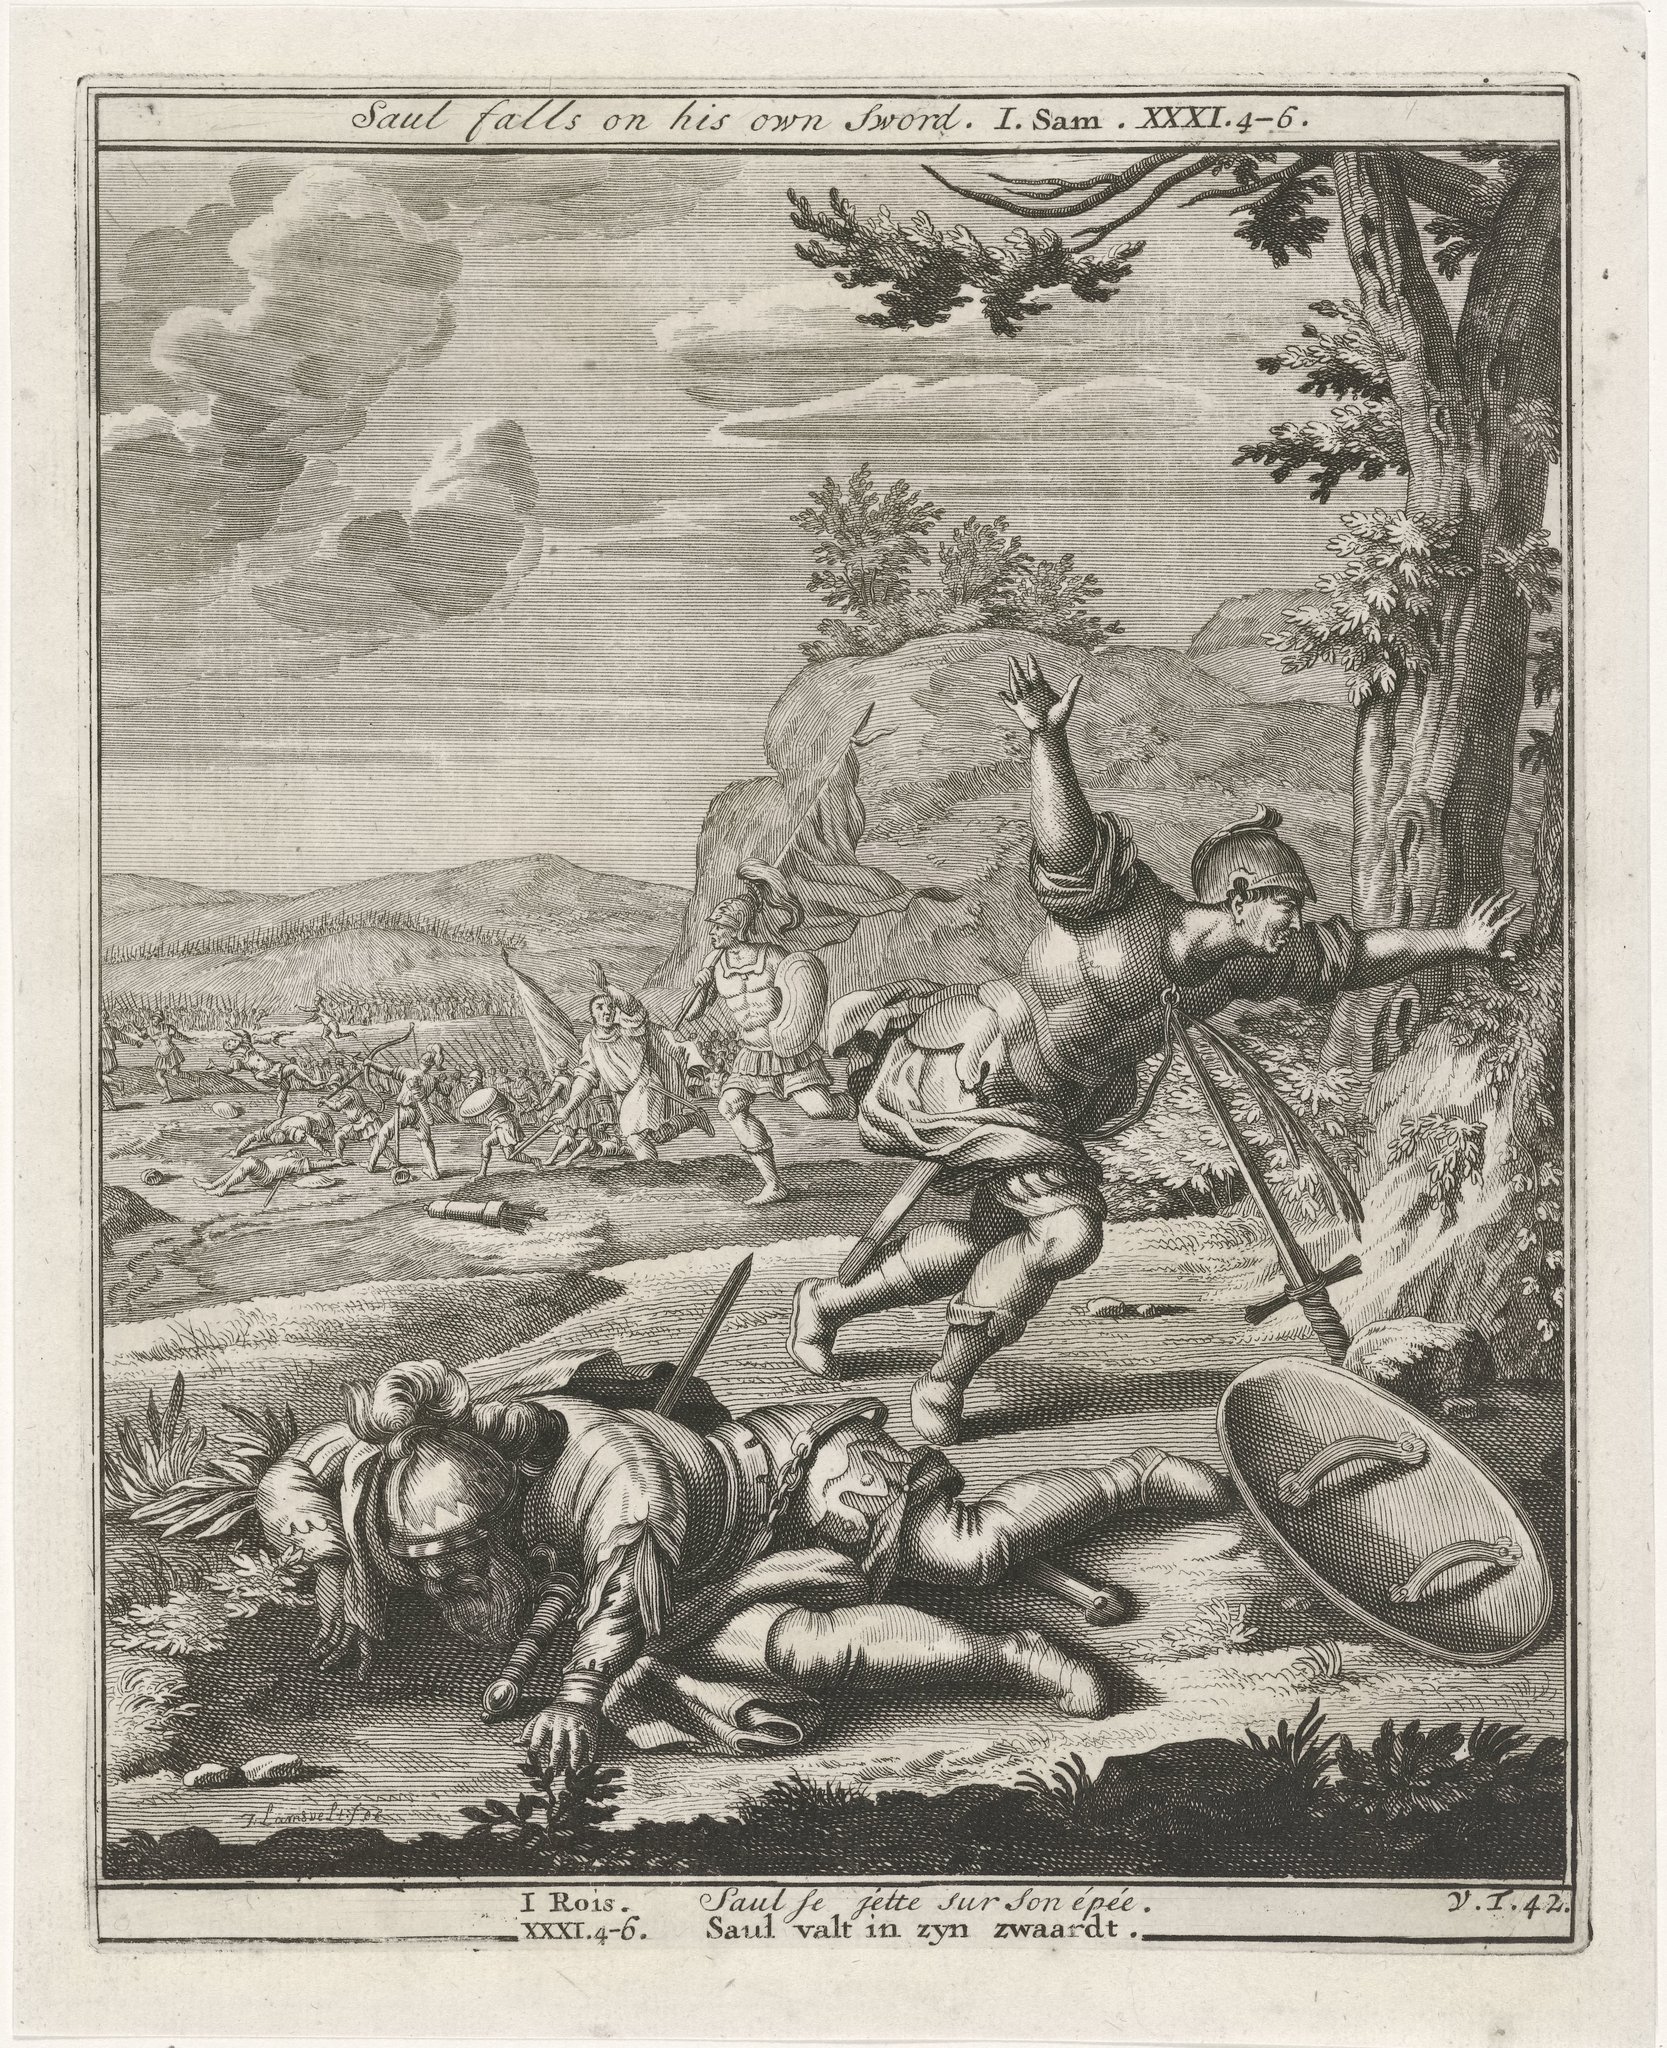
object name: print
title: Saul falls on his own sword / Saul je jette sur son épée / Saul valt in zyn zwaardt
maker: jan lamsvelt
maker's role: print maker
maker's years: 1674-1743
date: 1684-1743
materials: paper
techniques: engraving, etching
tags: saul kills himself with a sword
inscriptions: collector's mark: Lugt 2228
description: Bijbelse voorstelling uit 1 Sam. 31:4-6. Koning Saul, rechts in wapenrusting, stort zich in zijn eigen zwaard. Links ligt Saul's wapendrager met een zwaard door zijn borst op de grond. In de verte is een leger in gevecht. Prent rechtsonder gemerkt: V.T. 42.